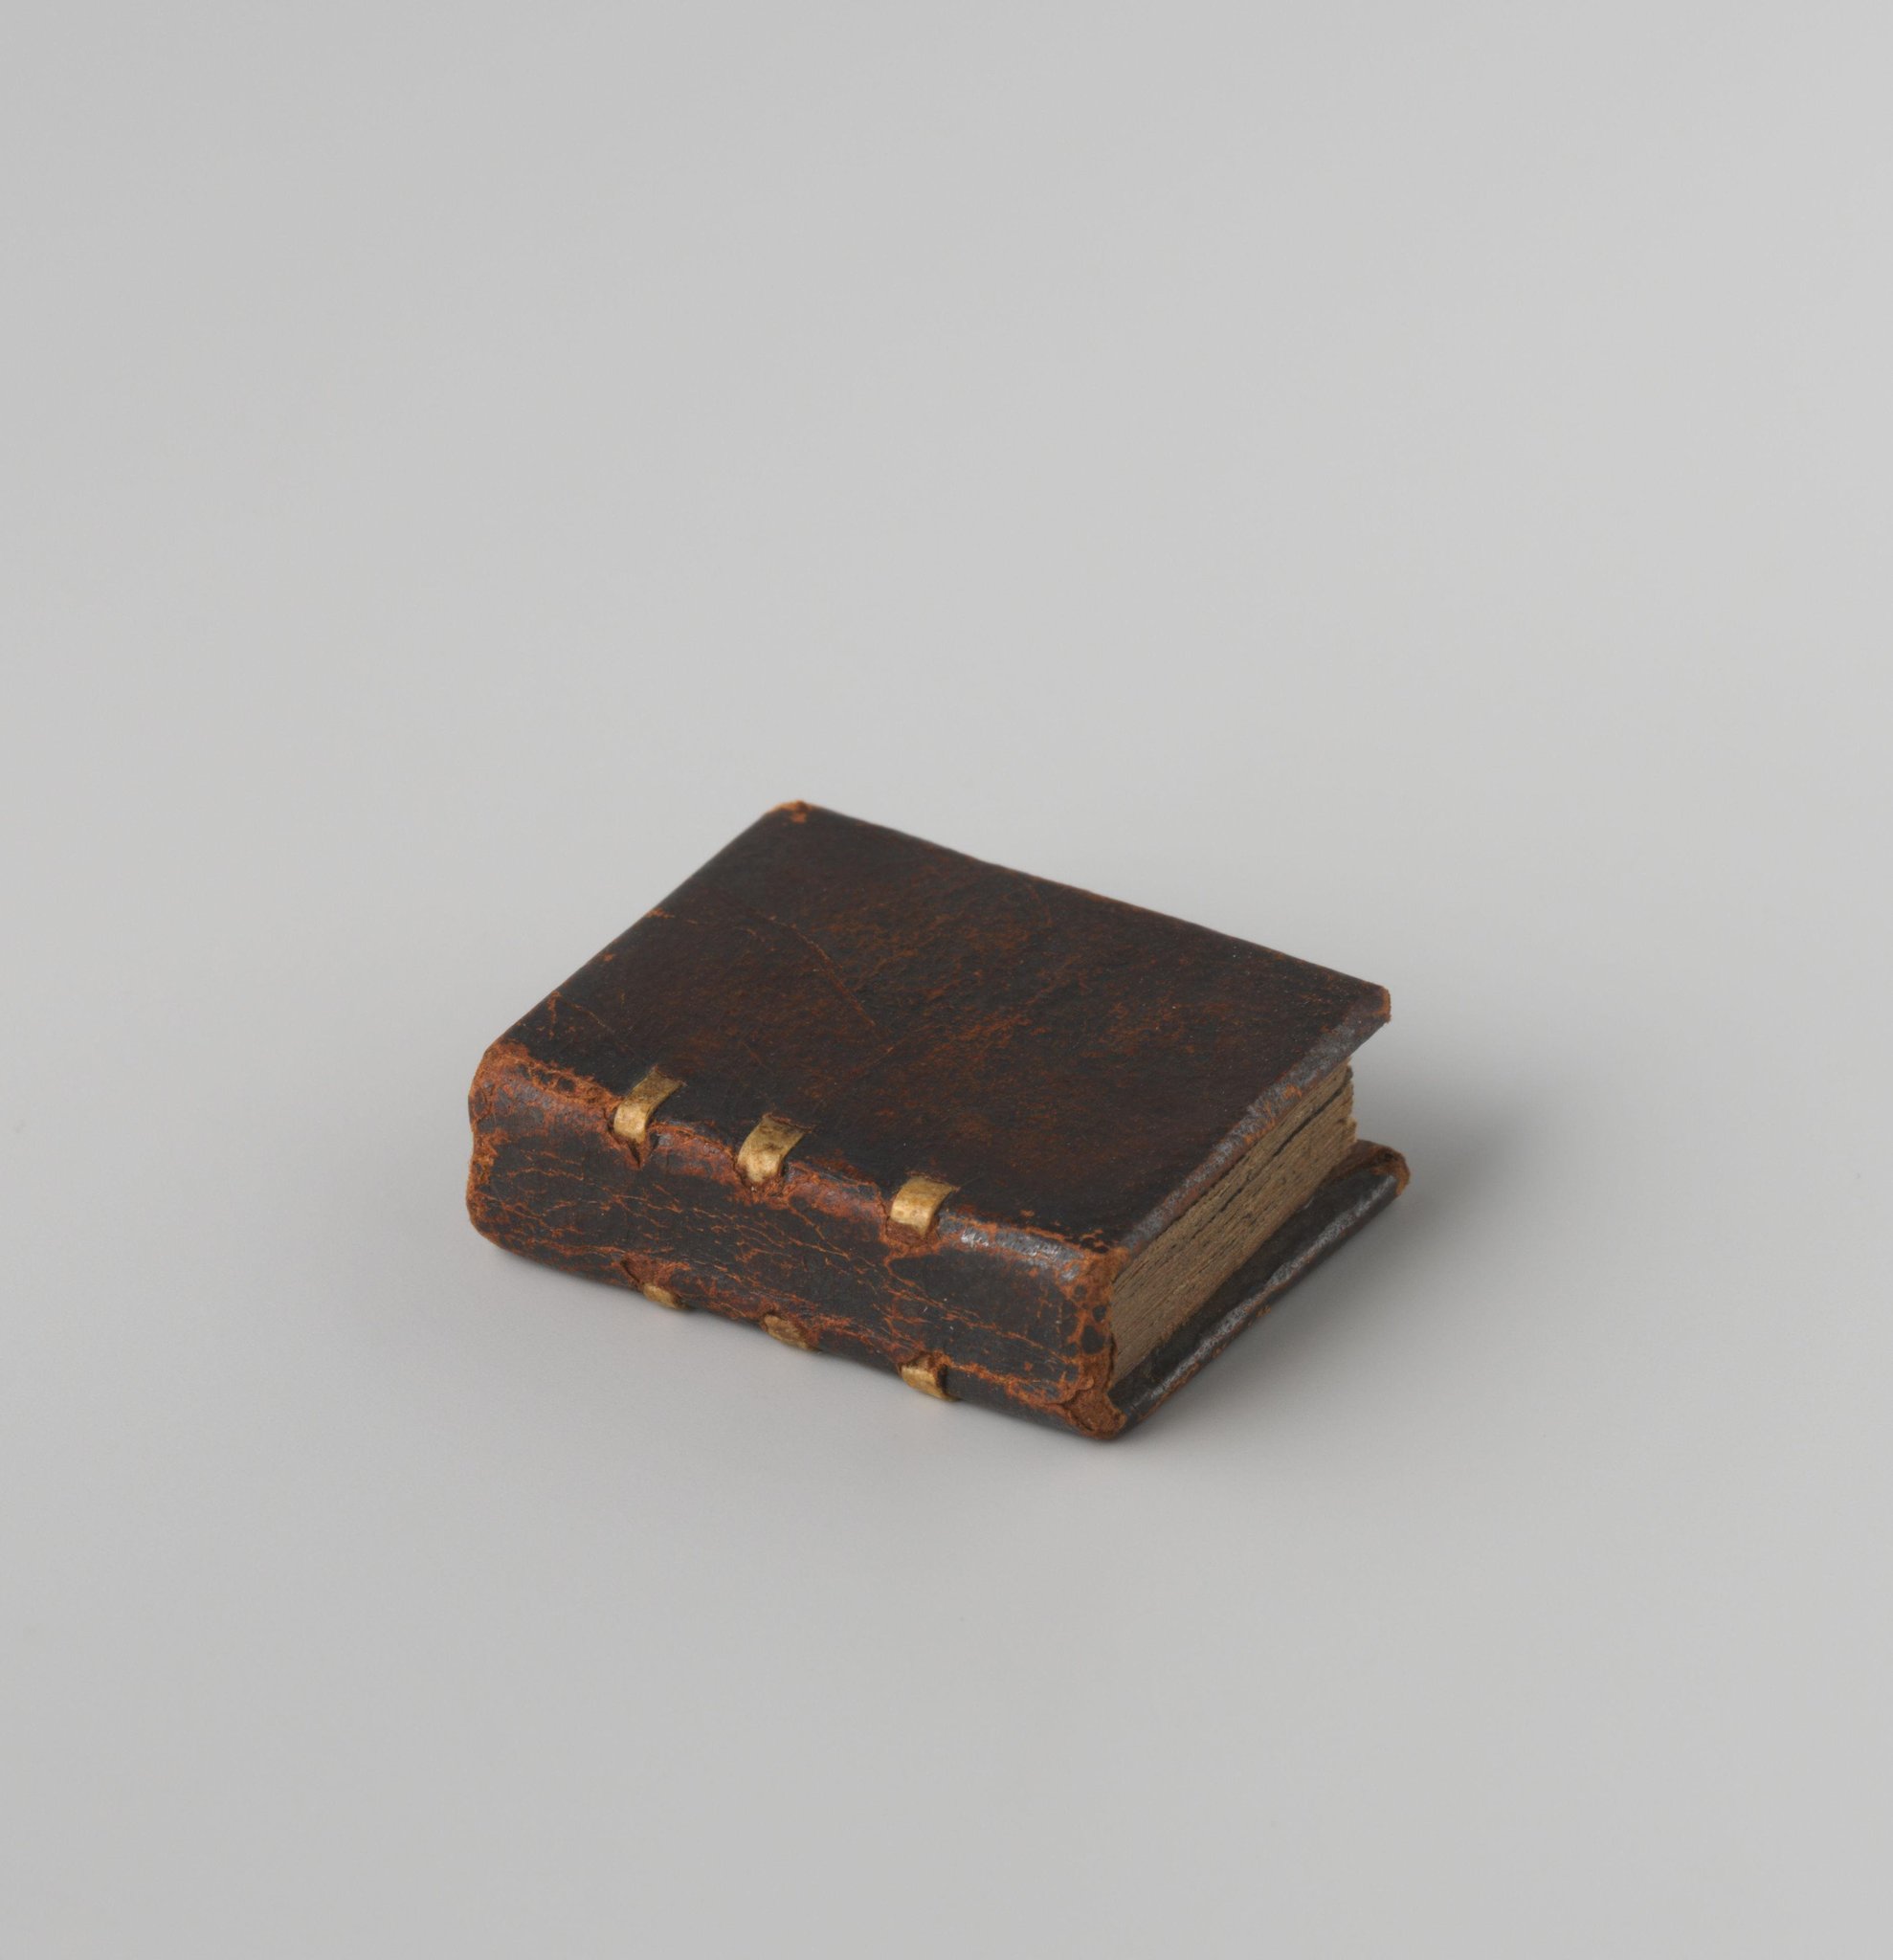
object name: ordinary of arm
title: Wapenboek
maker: Anonymous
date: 1690-1710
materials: leather, paper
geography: amsterdam